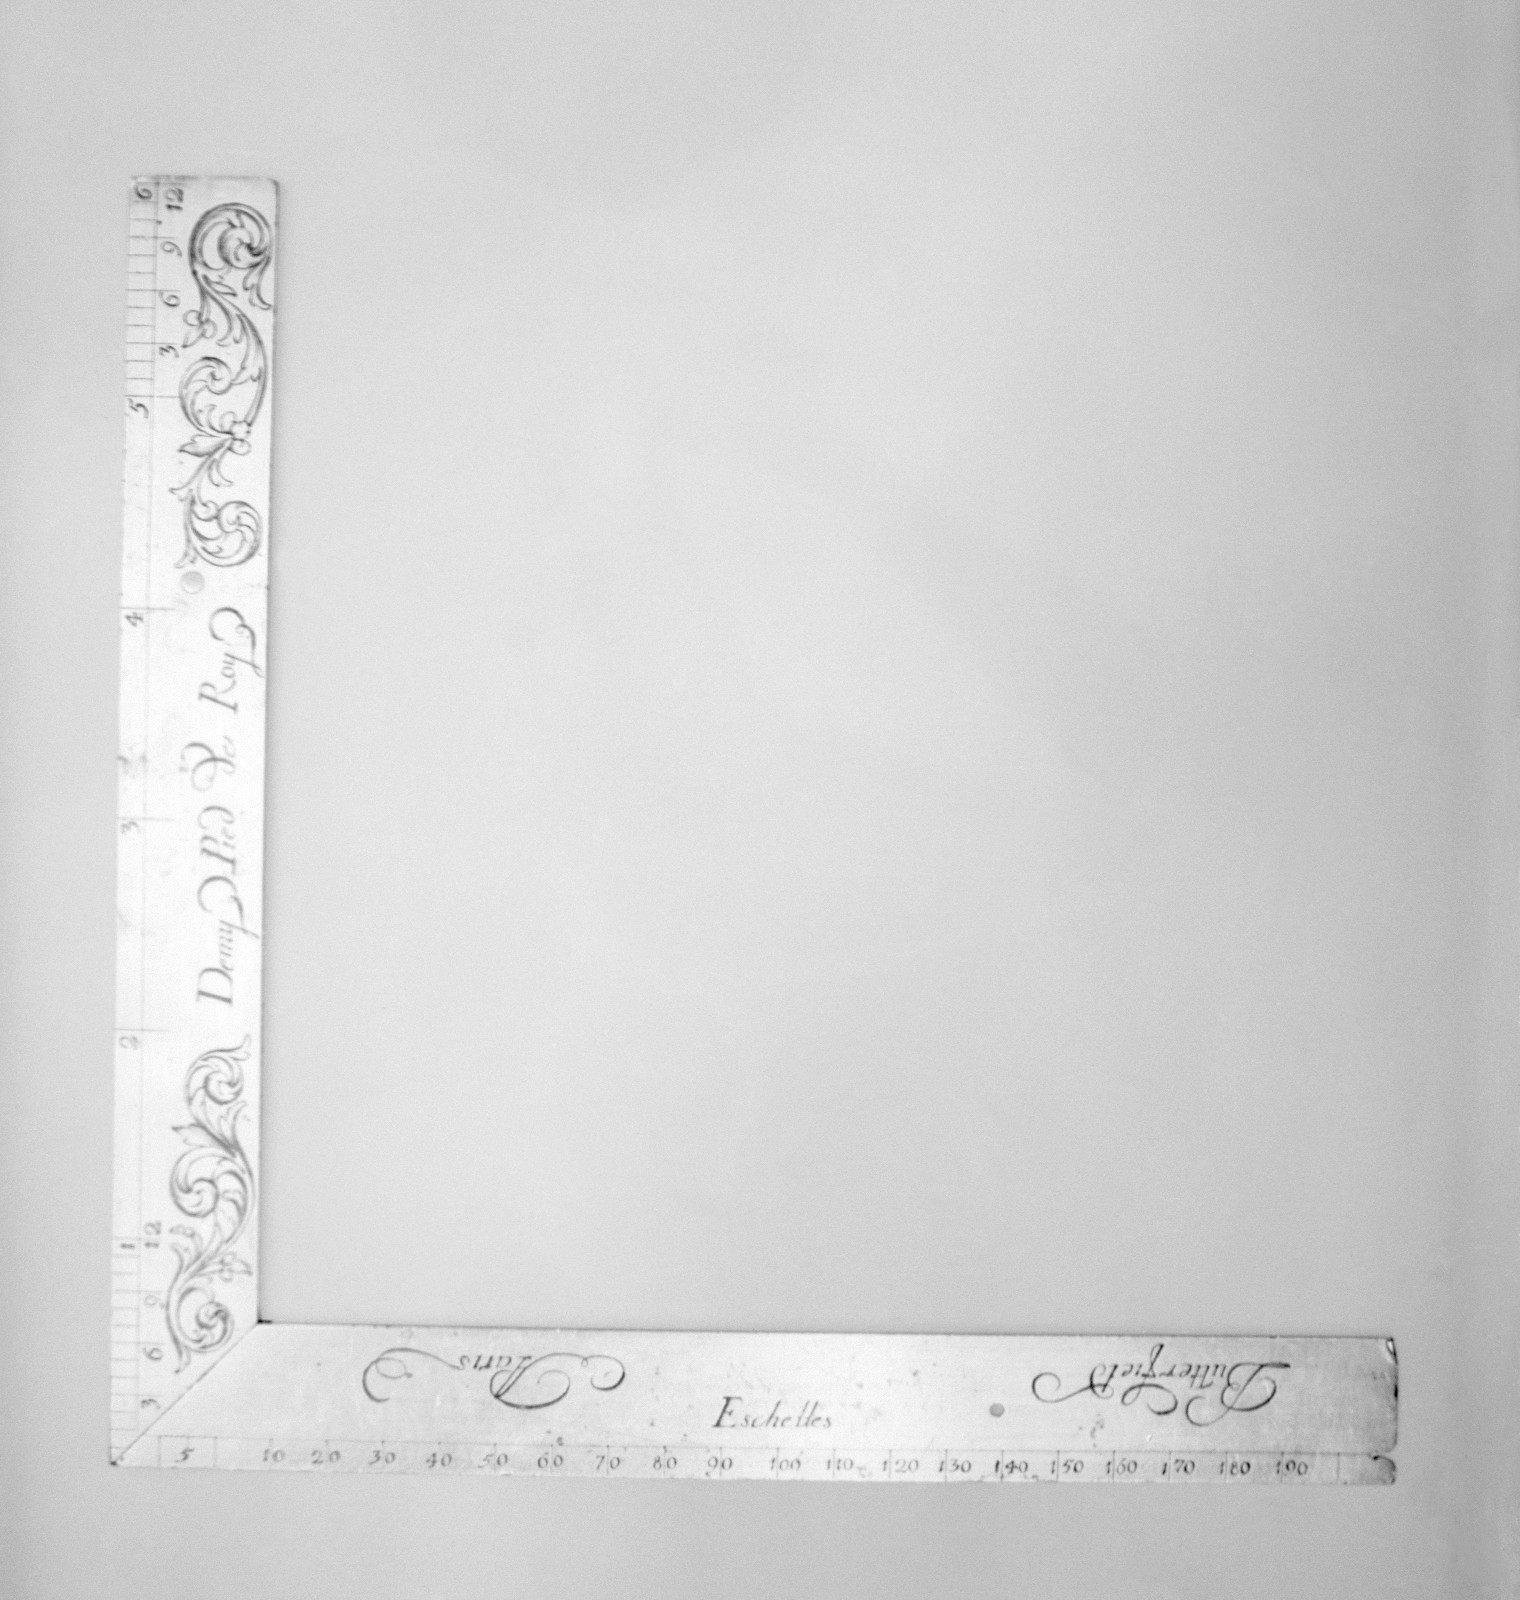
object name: folding square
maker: michael butterfield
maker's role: maker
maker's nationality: english, active in paris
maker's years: 1635-1724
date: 1667-1733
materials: brass